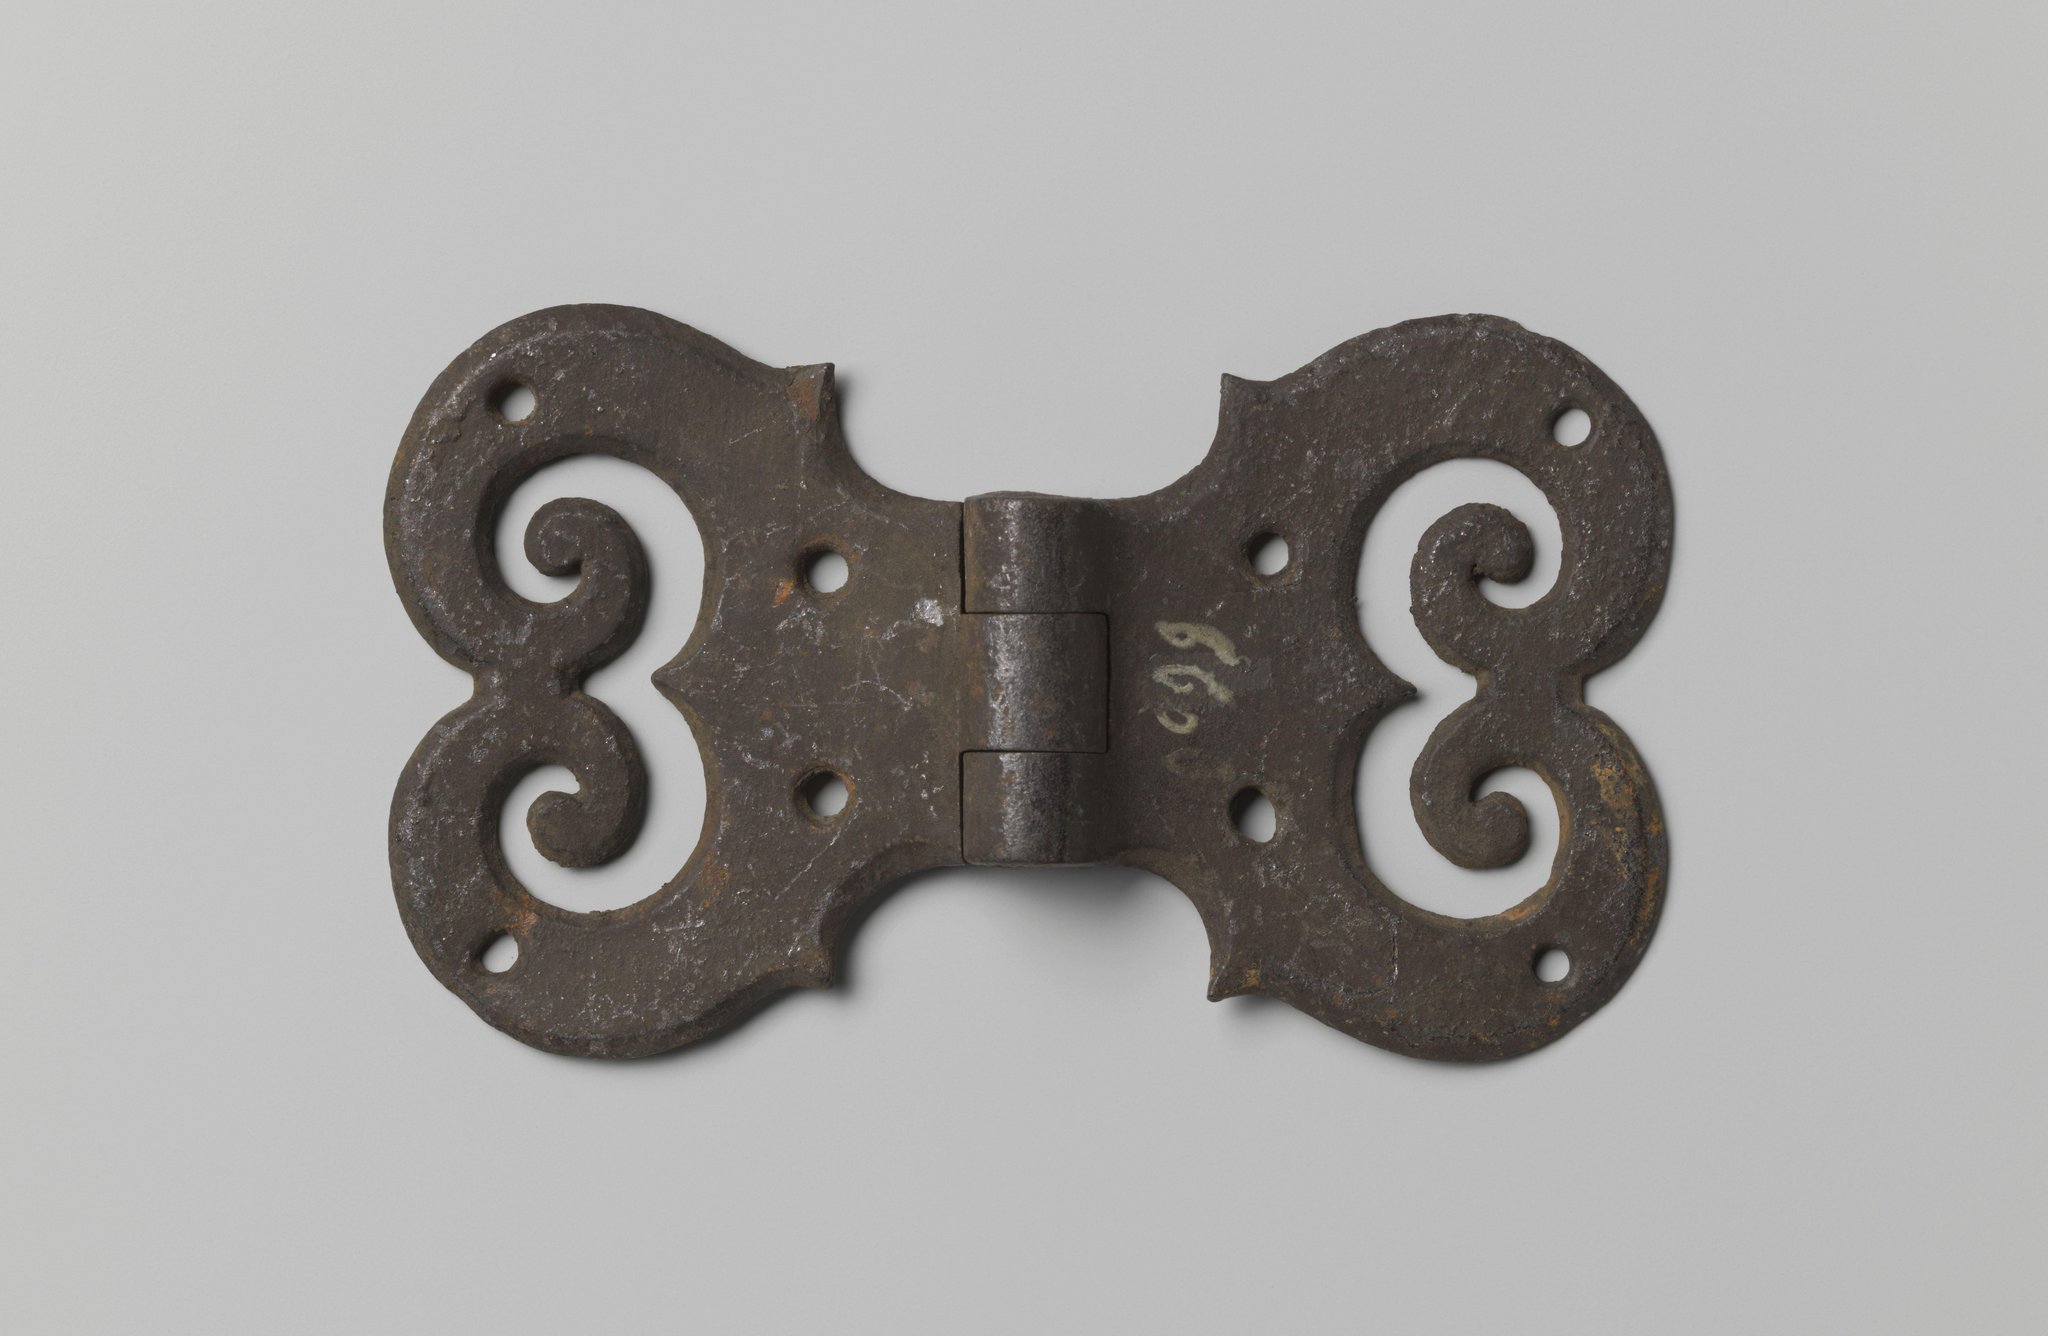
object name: scharnier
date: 1400-1950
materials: iron